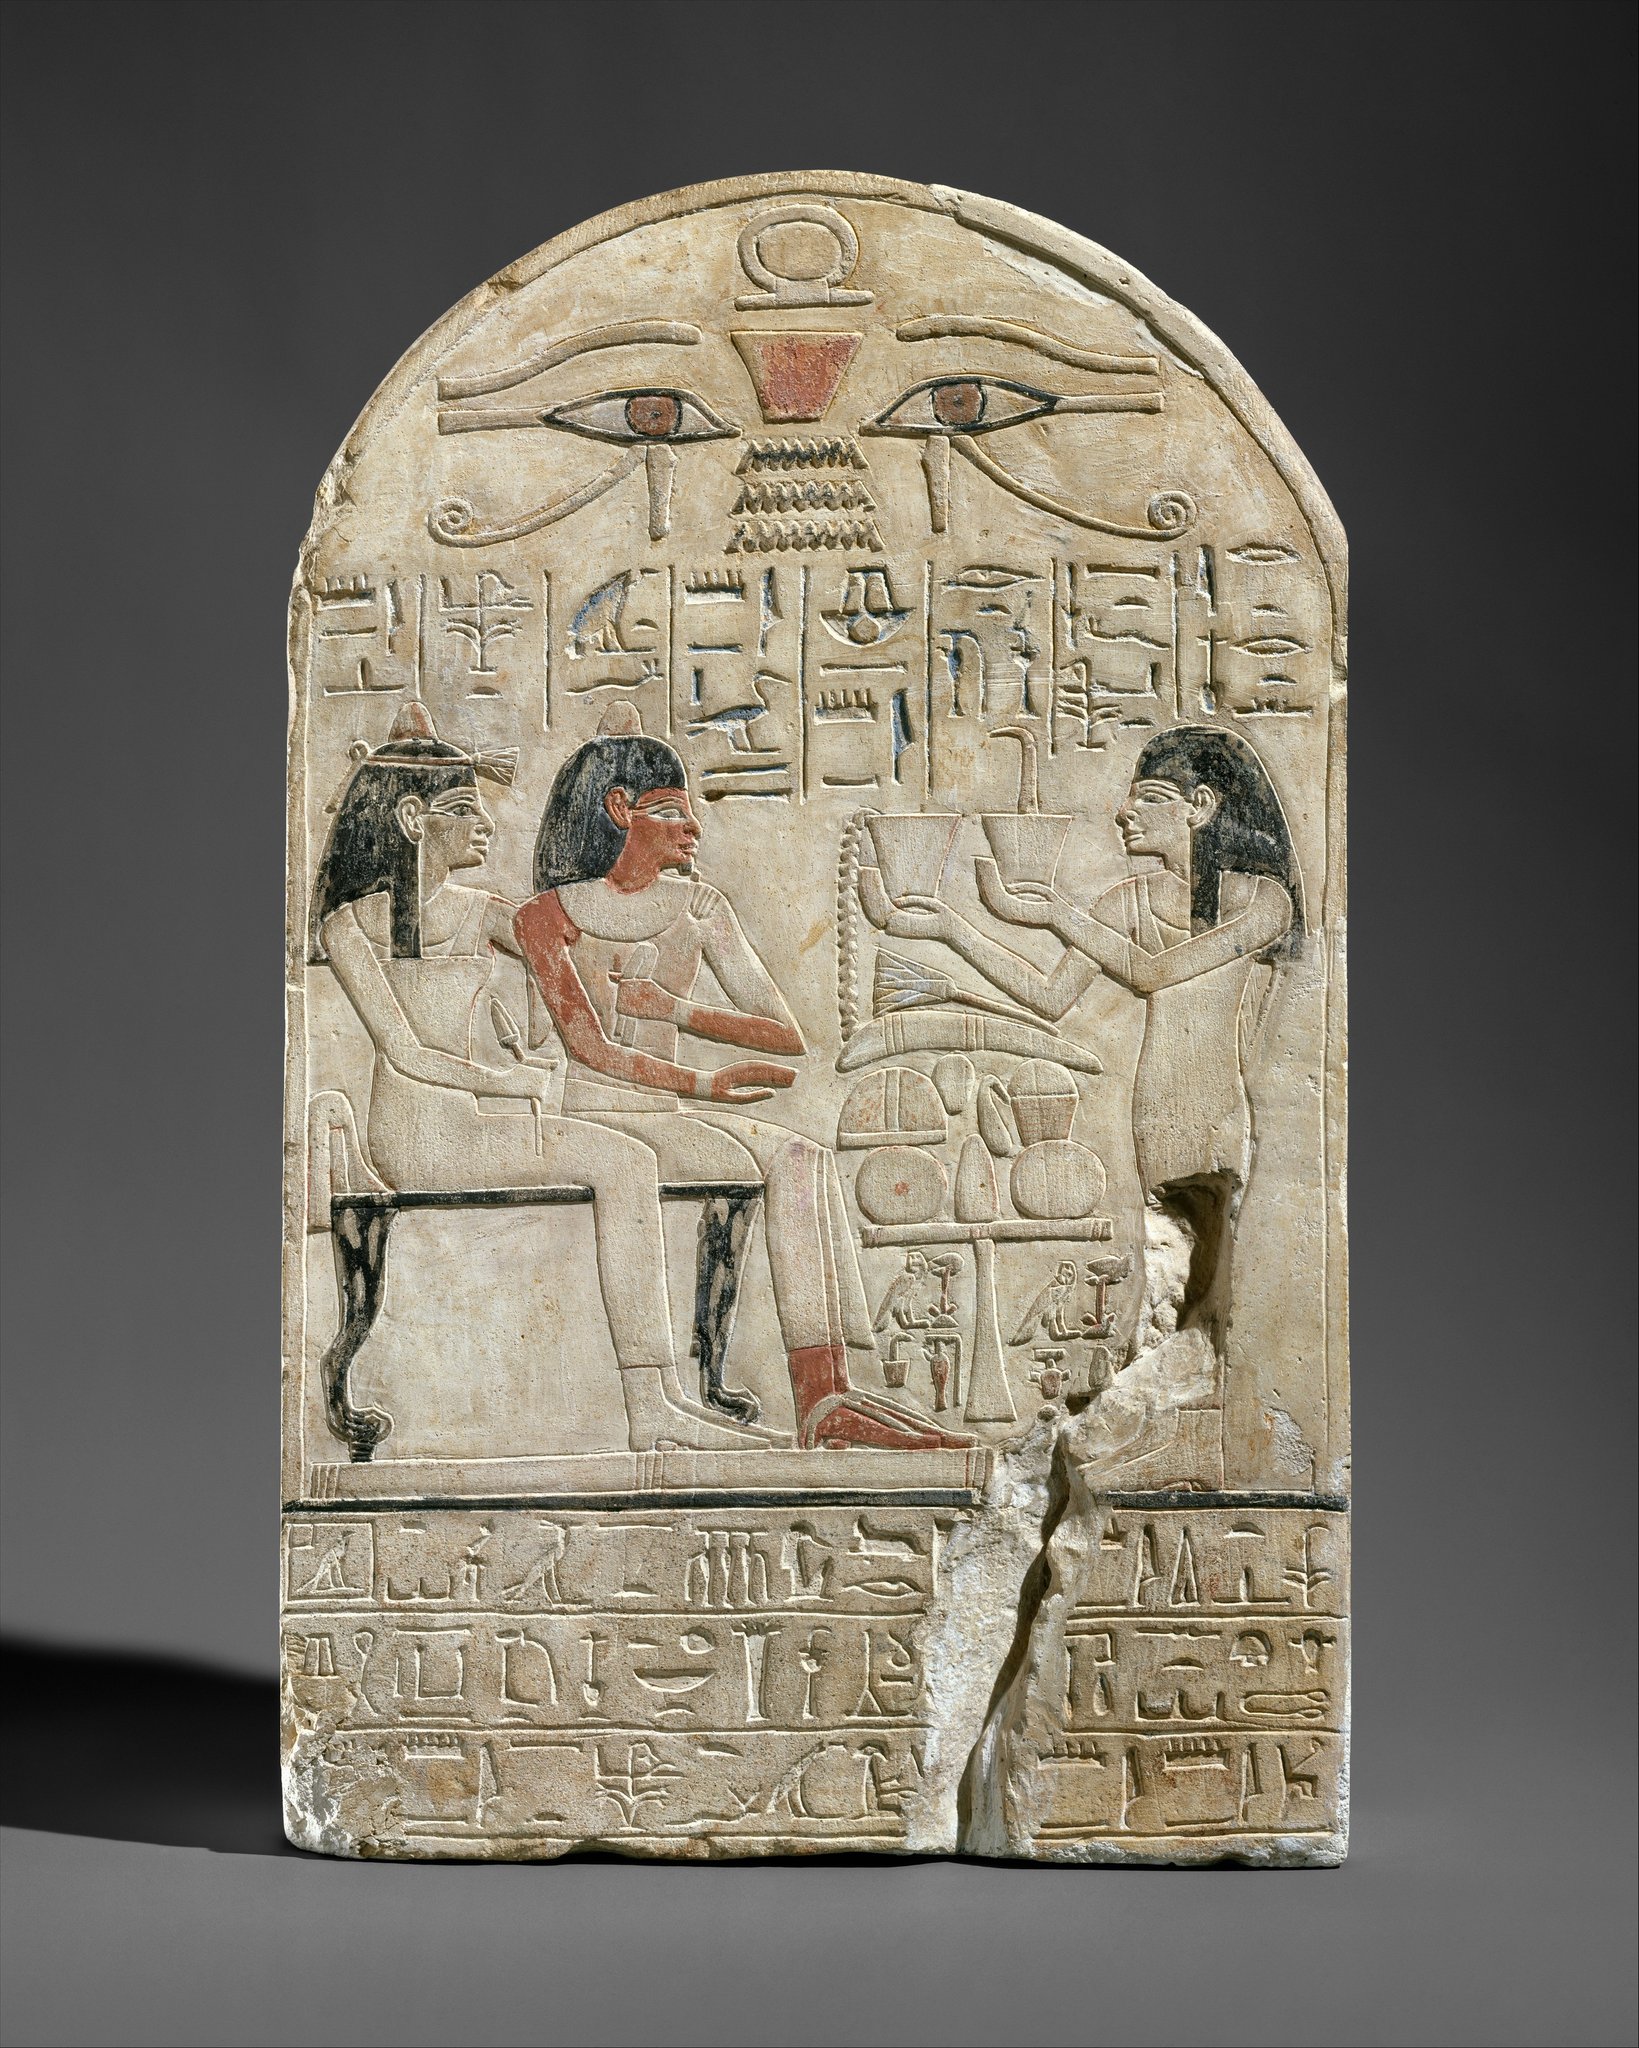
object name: stela, siamun, singer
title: Stela of the lector priest of Amun Siamun and his mother the singer Amenhotep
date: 1420 BCE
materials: limestone, paint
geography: egypt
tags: food,men,women,hieroglyphs